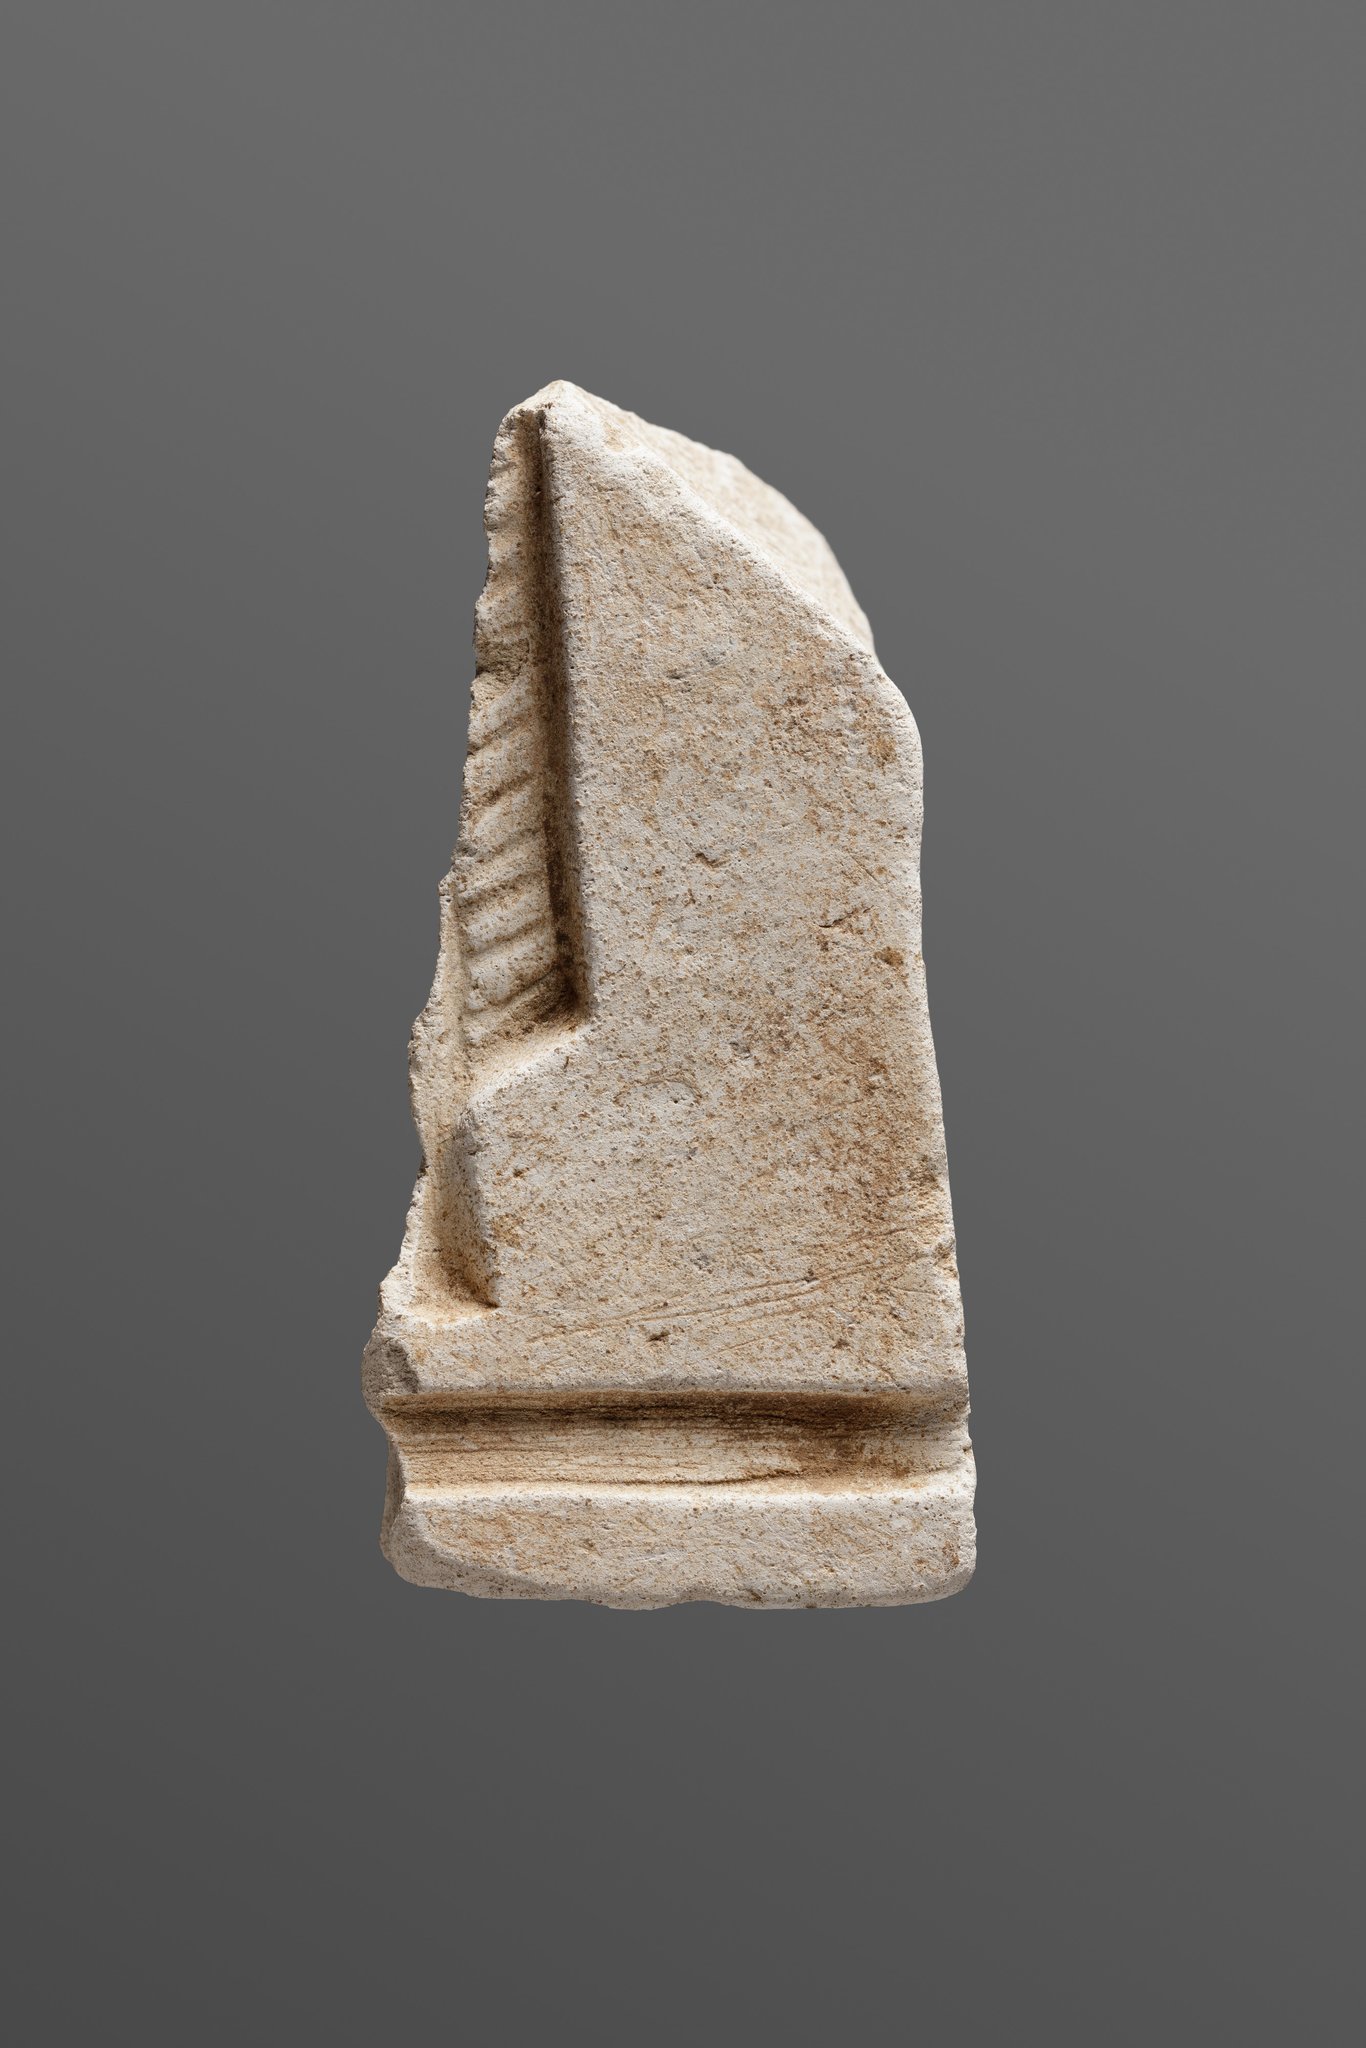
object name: relief fragment 47, tomb of mereri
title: Relief fragment possibly from the tomb of Mereri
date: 2100-2090 BCE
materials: stone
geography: egypt